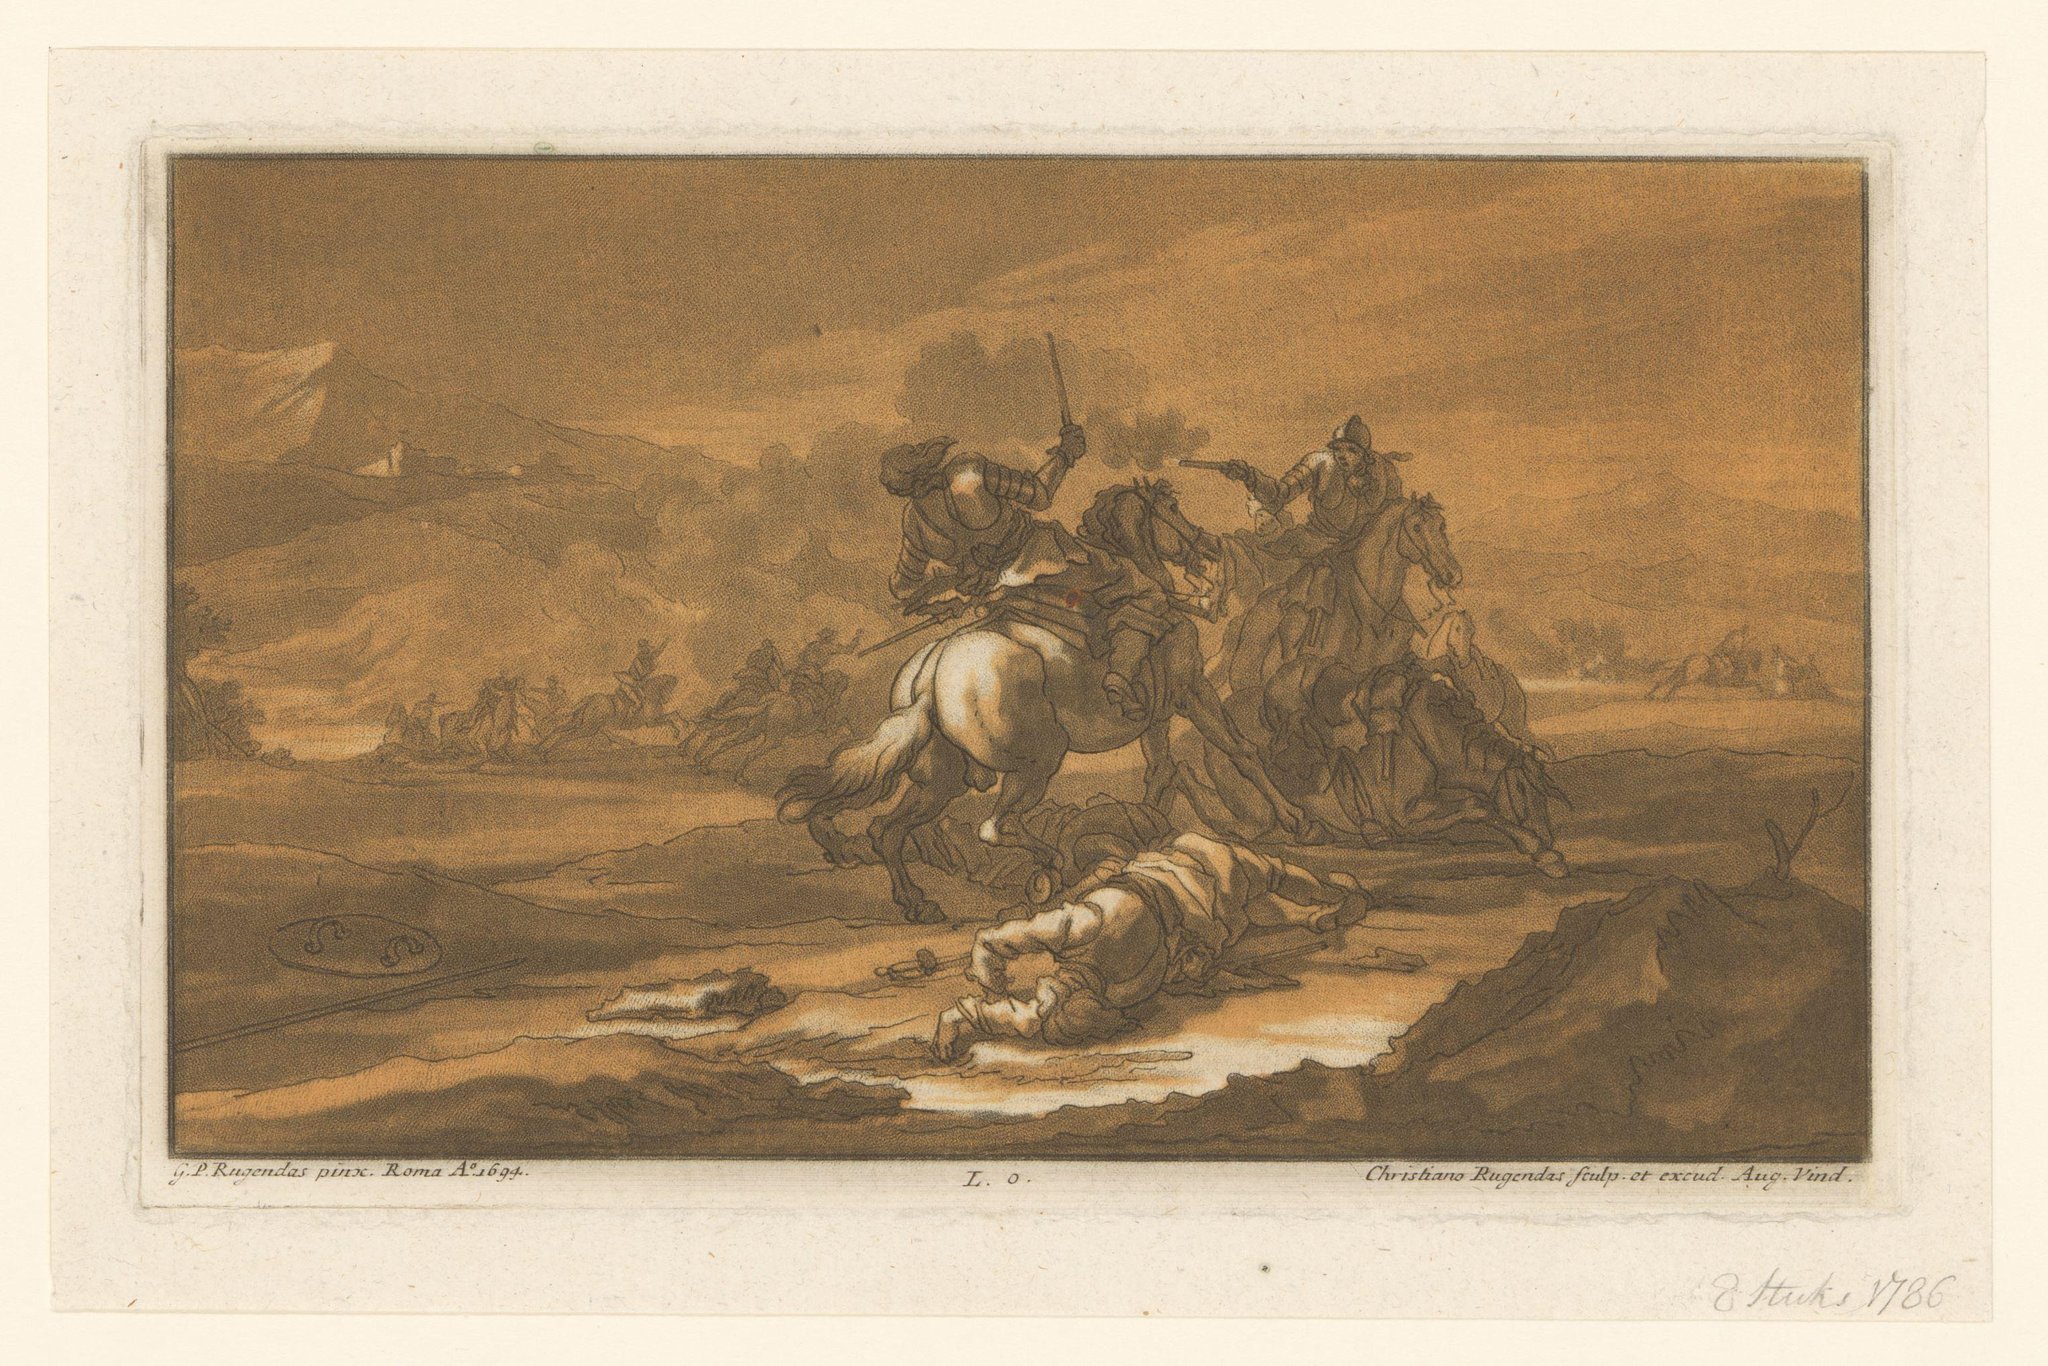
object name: print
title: Gevecht tussen ruiters in harnas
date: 1718-1781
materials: paper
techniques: etching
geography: augsburg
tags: riding a horse, ass, or mule; rider, horseman, armour, battle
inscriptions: collector's mark: Lugt 2228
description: Onderdeel van een serie van 64 prenten door Christian Rugendas naar Georg Philipp Rugendas.